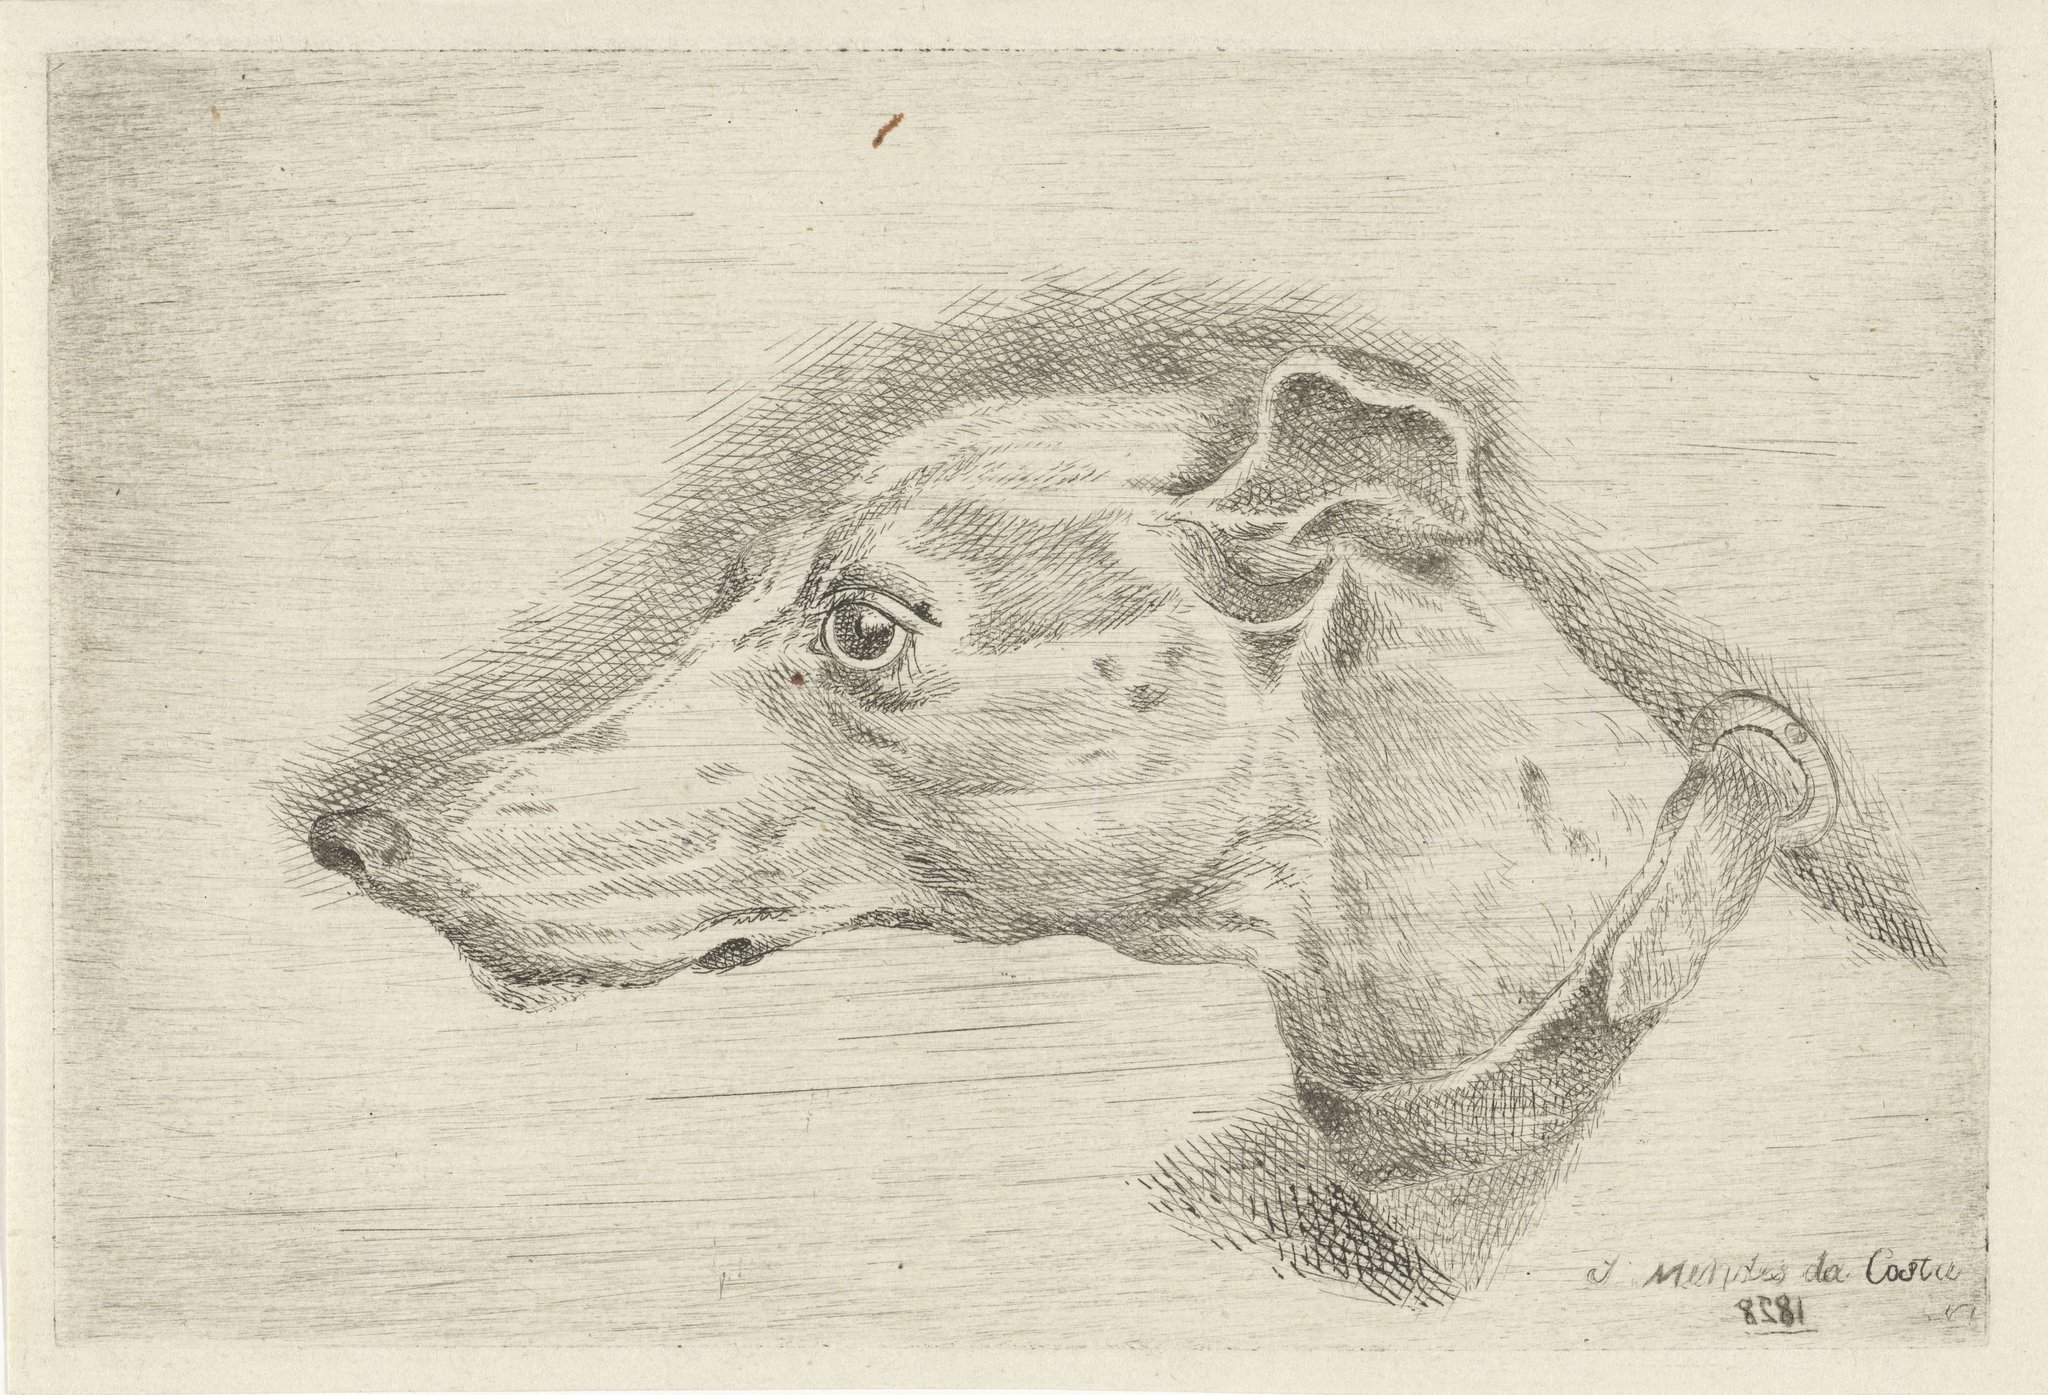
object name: print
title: Kop van een hazewindhond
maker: joseph mendes da costa (1806-1893)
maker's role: draughtsman, print maker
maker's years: 1806-1893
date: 1828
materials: paper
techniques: etching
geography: amsterdam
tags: dog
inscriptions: collector's mark: Lugt 2228